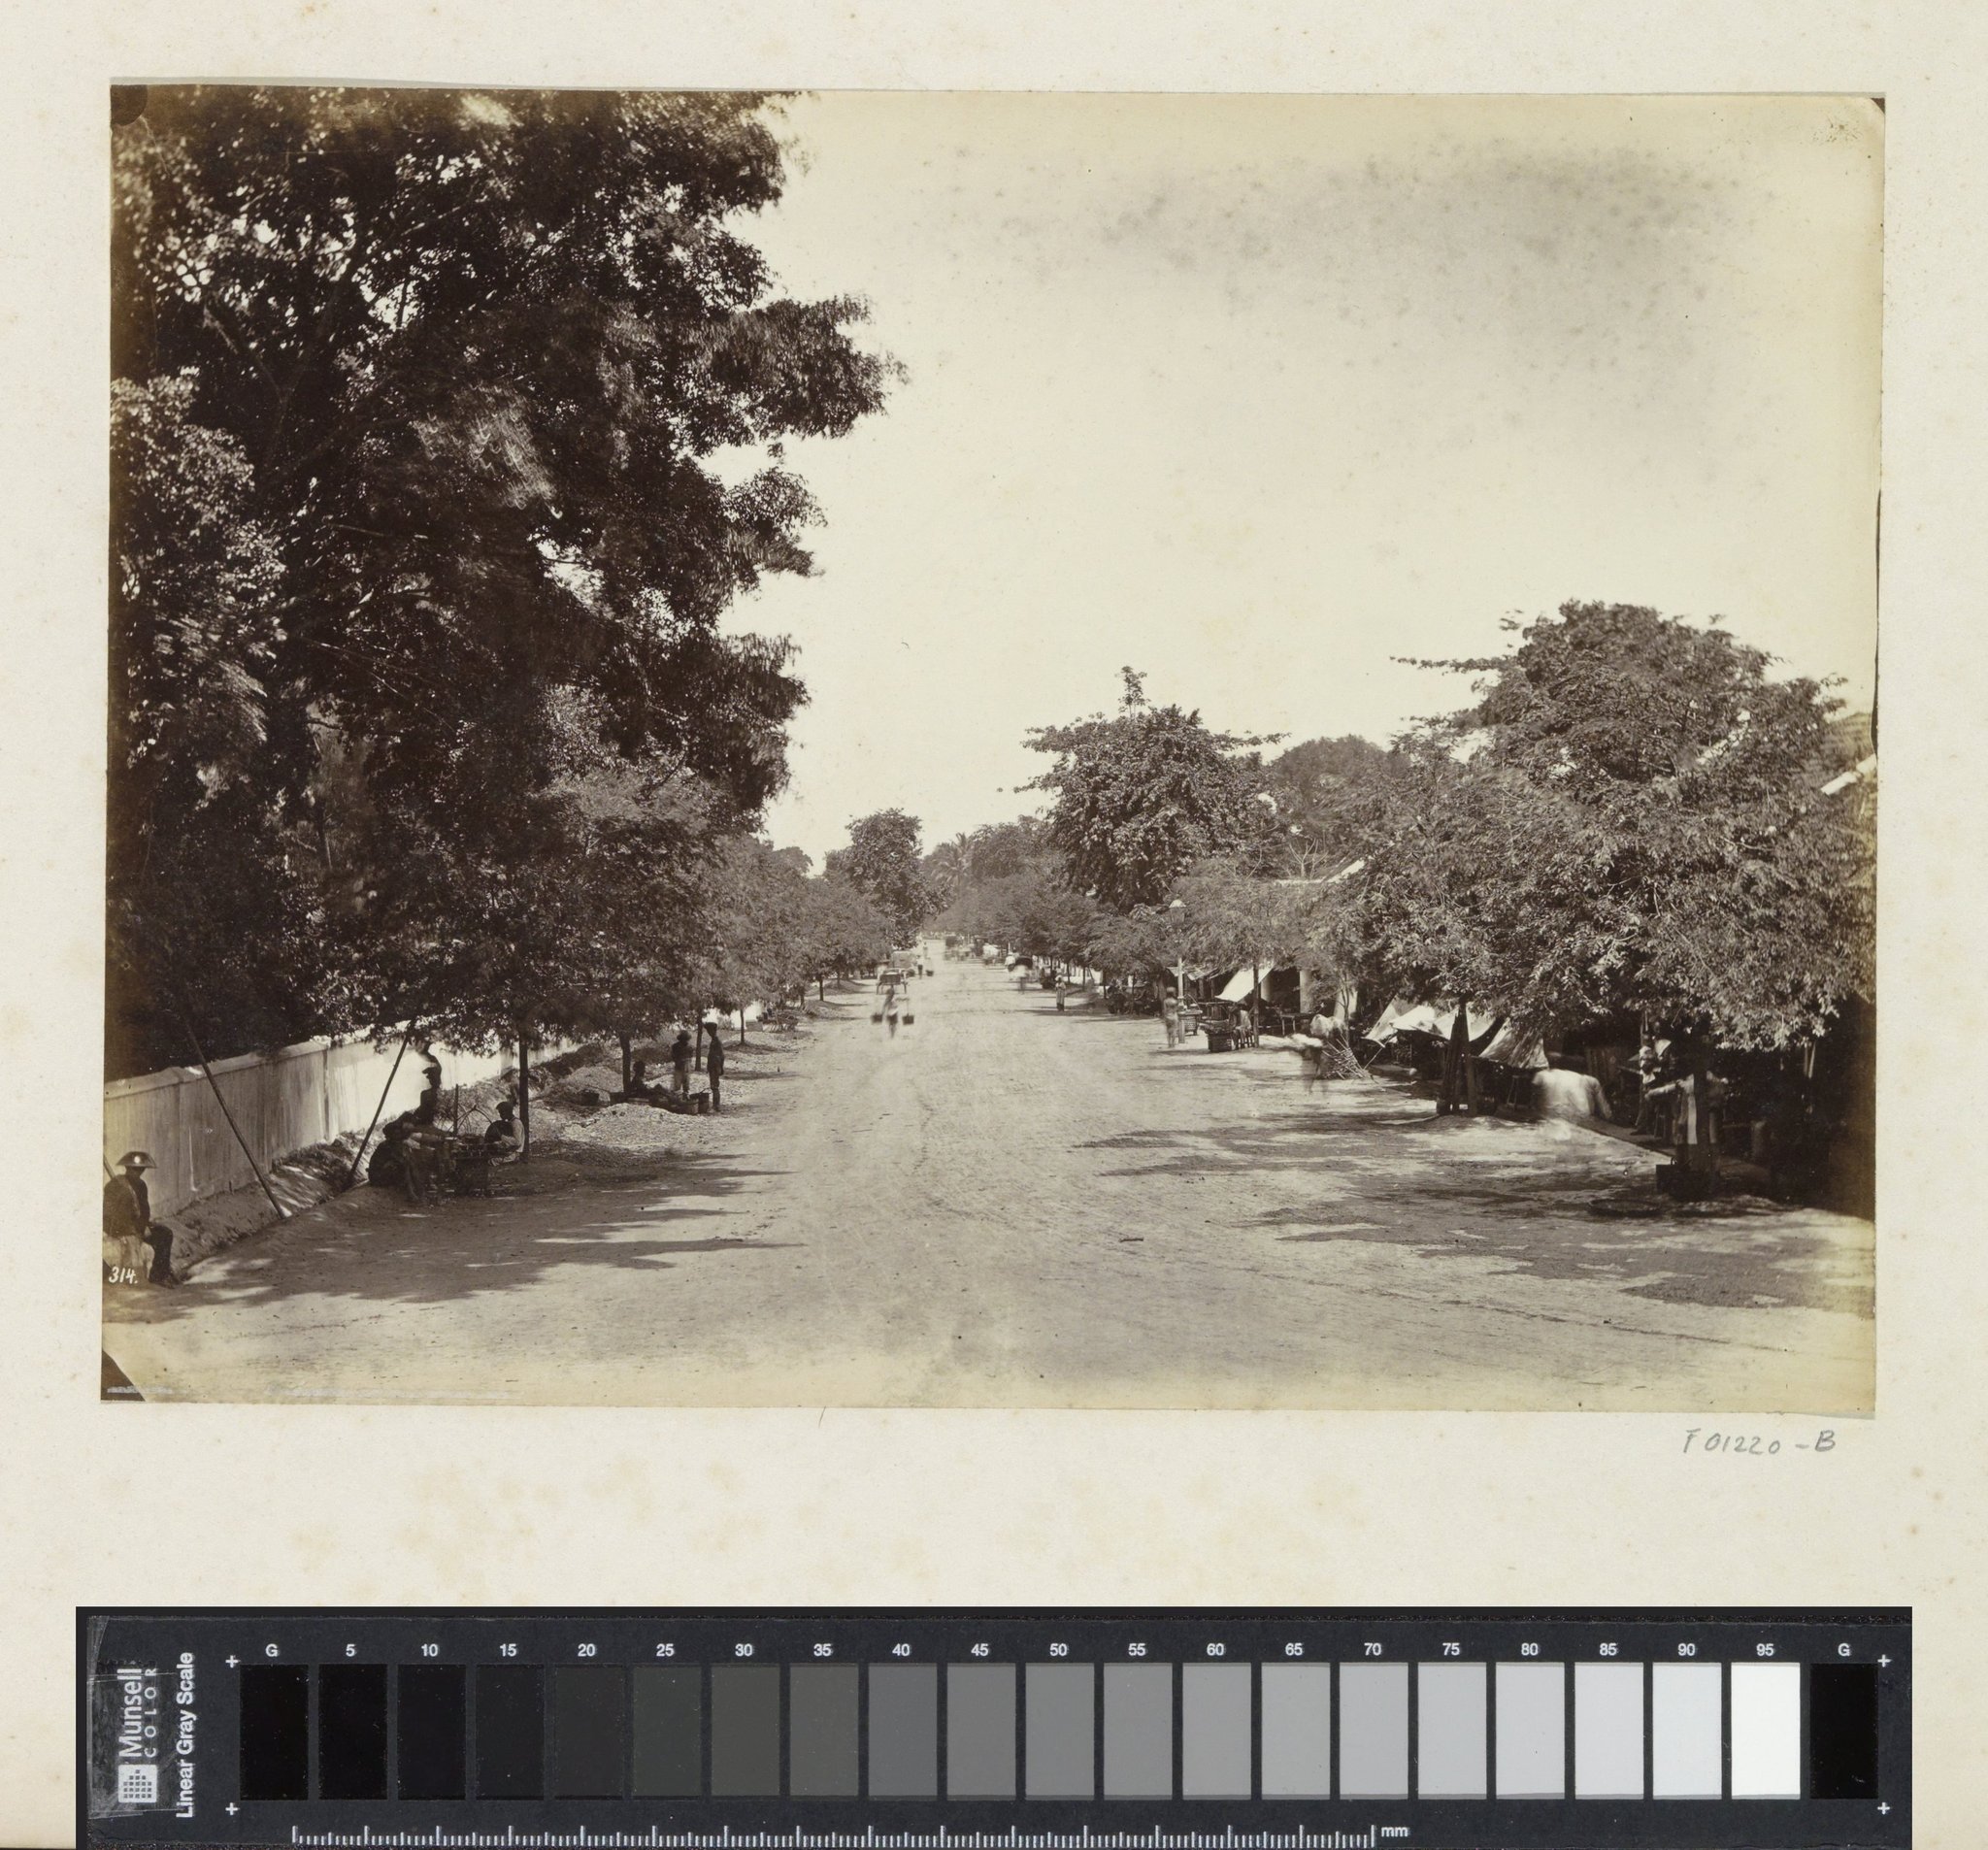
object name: photograph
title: Laan met winkels op Java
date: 1857-1870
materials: photographic support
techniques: albumen print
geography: java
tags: shop, store, forest path or lane, java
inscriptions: number: ‘314’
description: Onderdeel van Fotoalbum met opnames van bezienswaardigheden op Java.